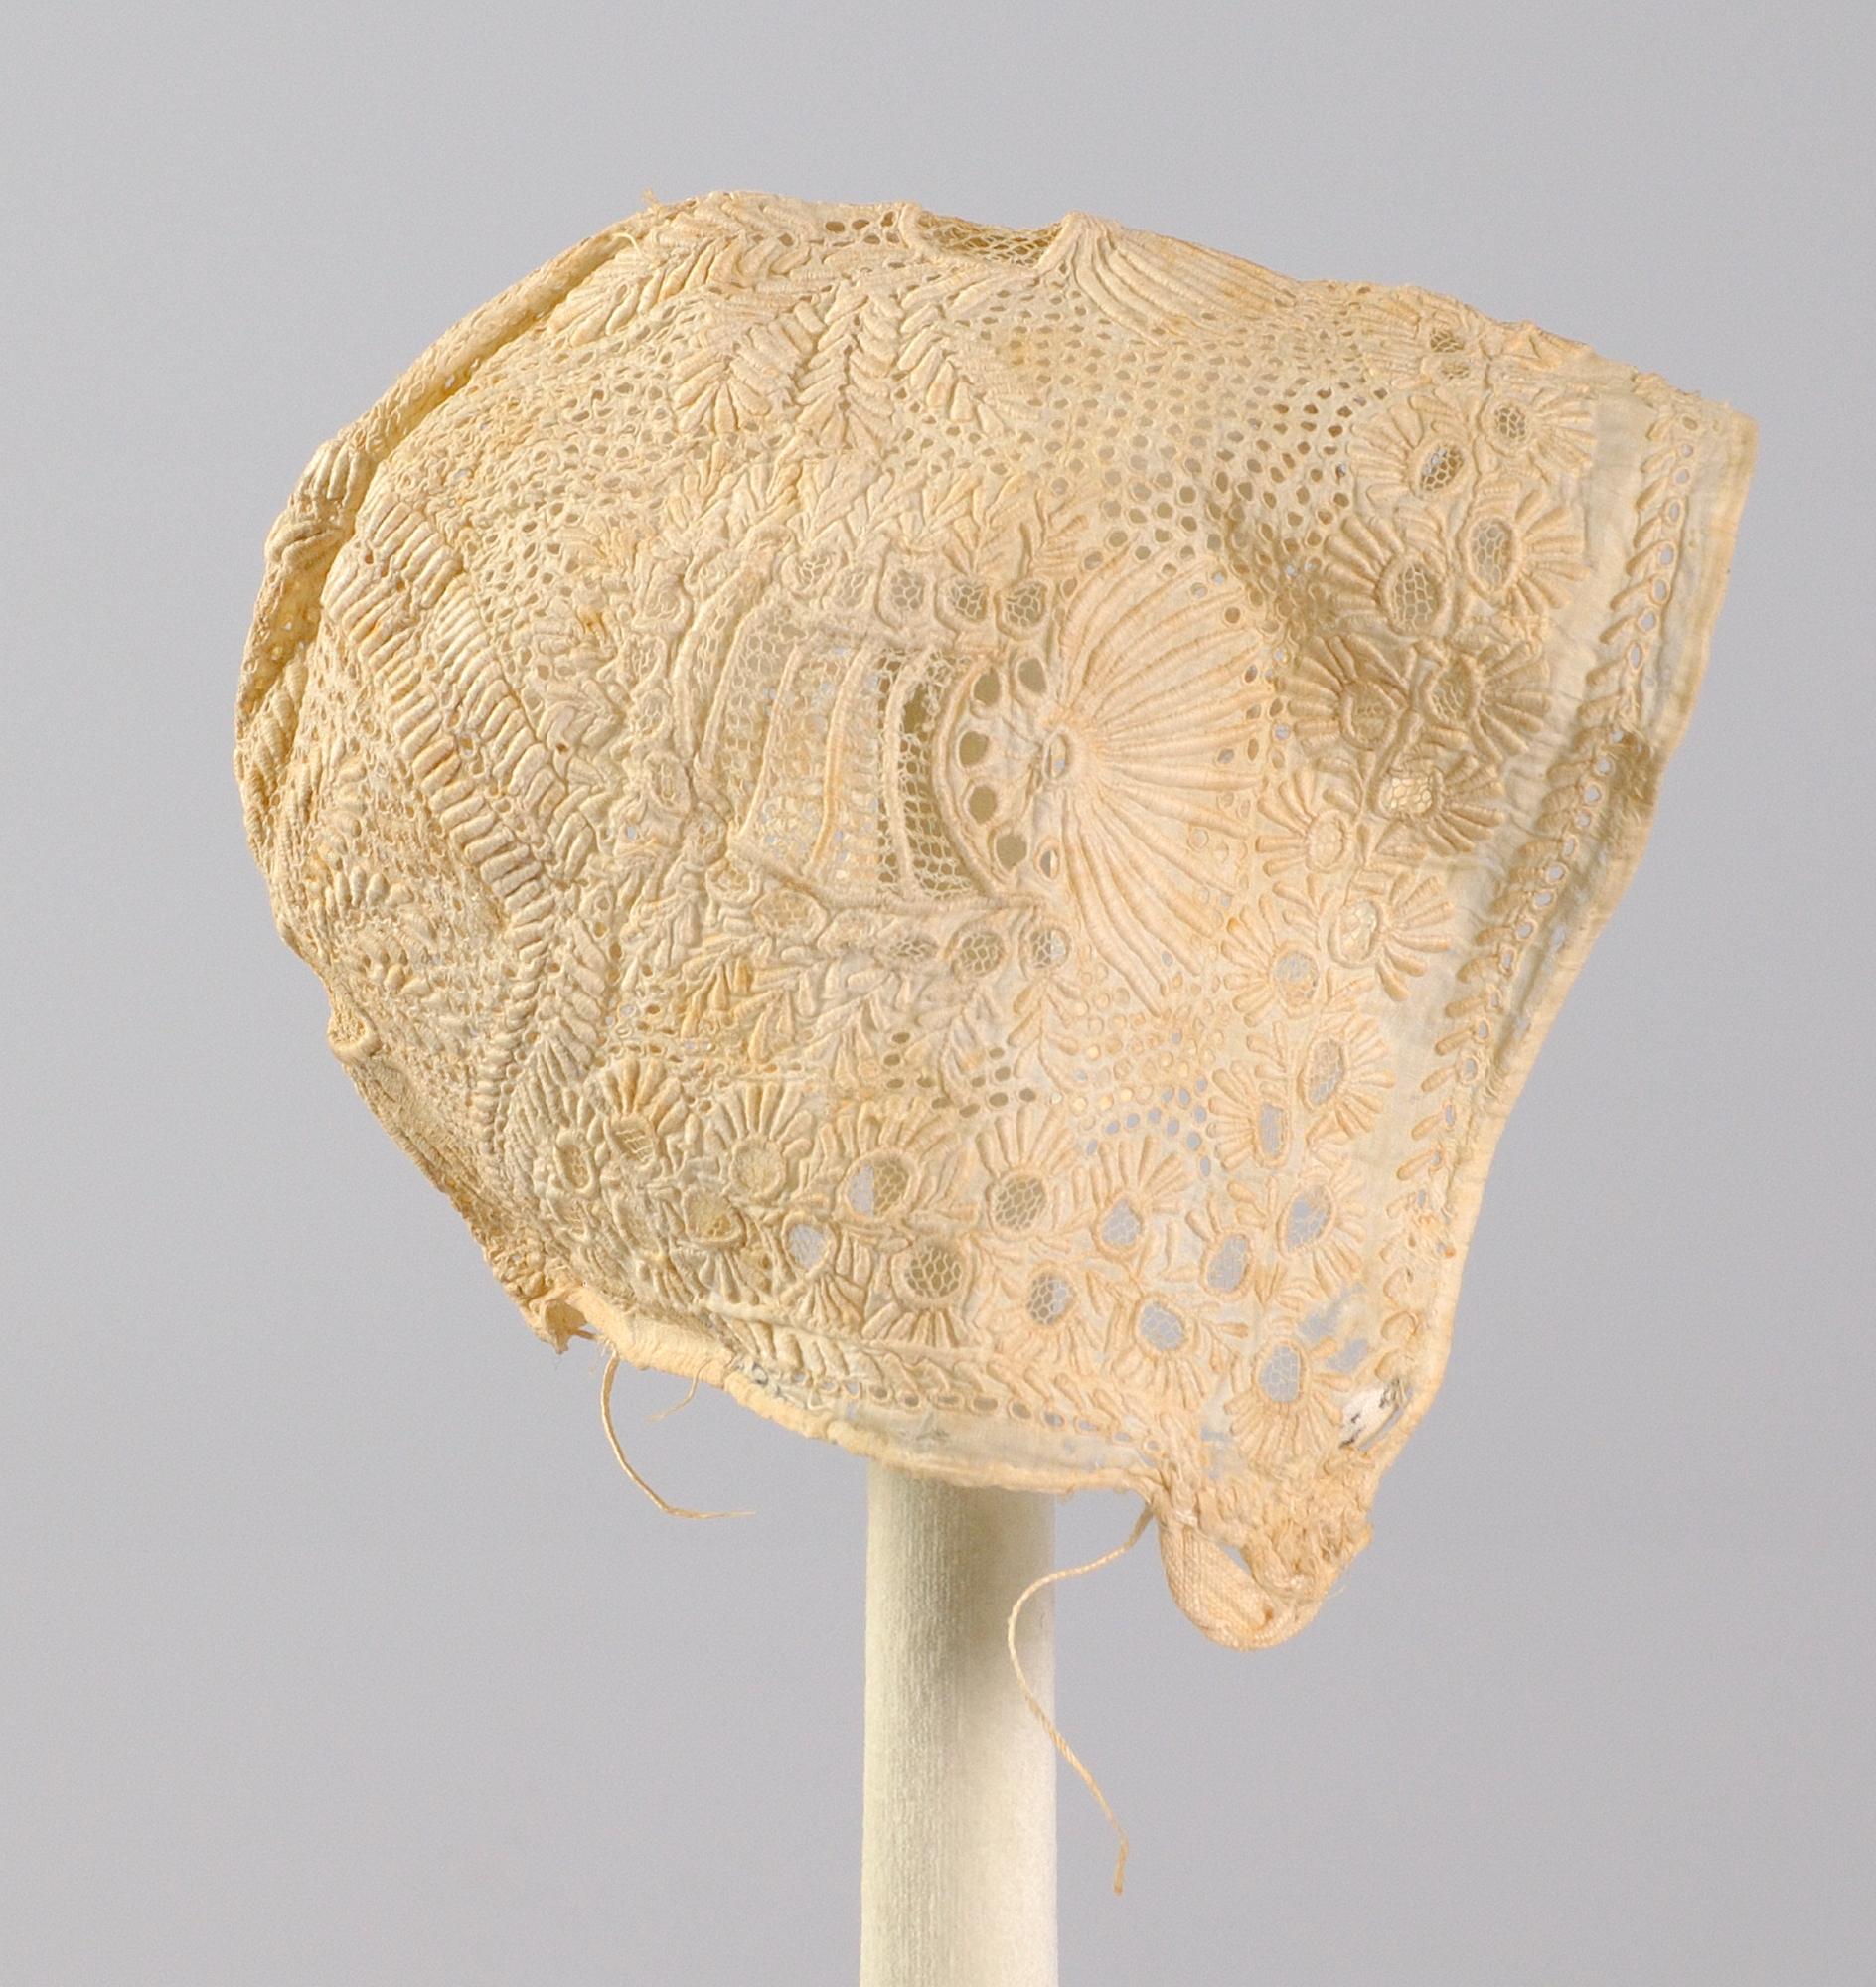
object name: cap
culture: american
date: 1830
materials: cotton